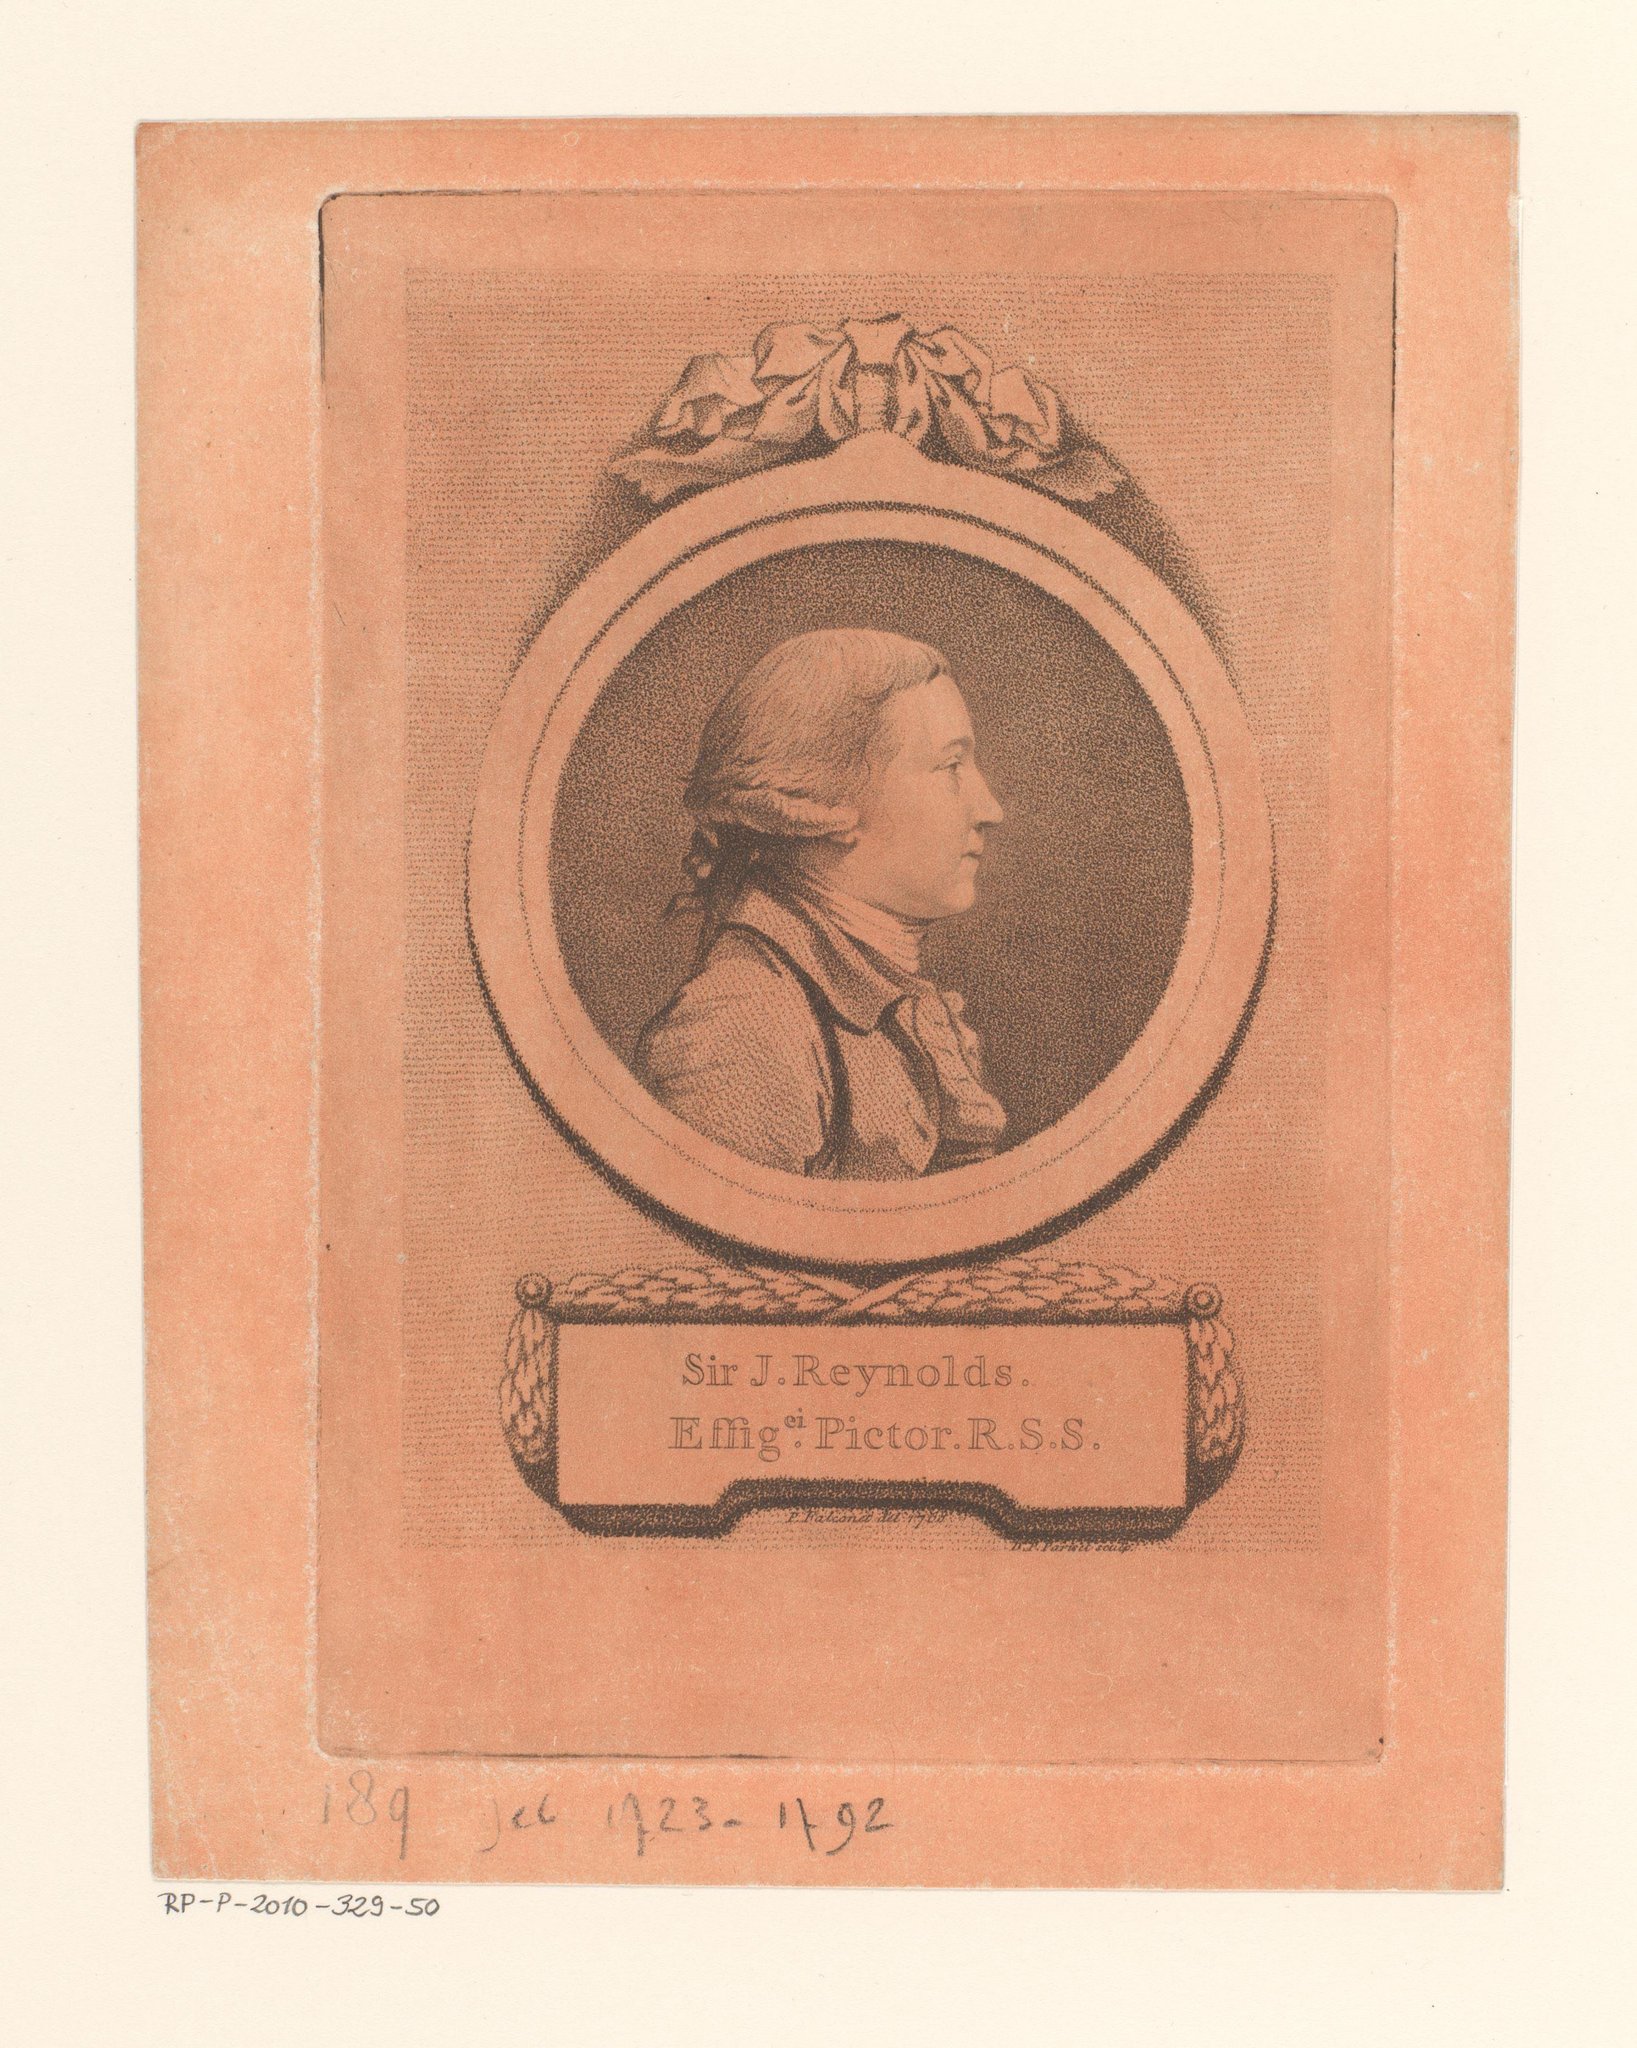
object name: print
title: Sir J. Reynolds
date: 1760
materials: paper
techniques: aquatint, printmaking, etching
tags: painter, joshua reynolds, historical persons, portrait, self-portrait of painter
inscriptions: collector's mark: Lugt 2228